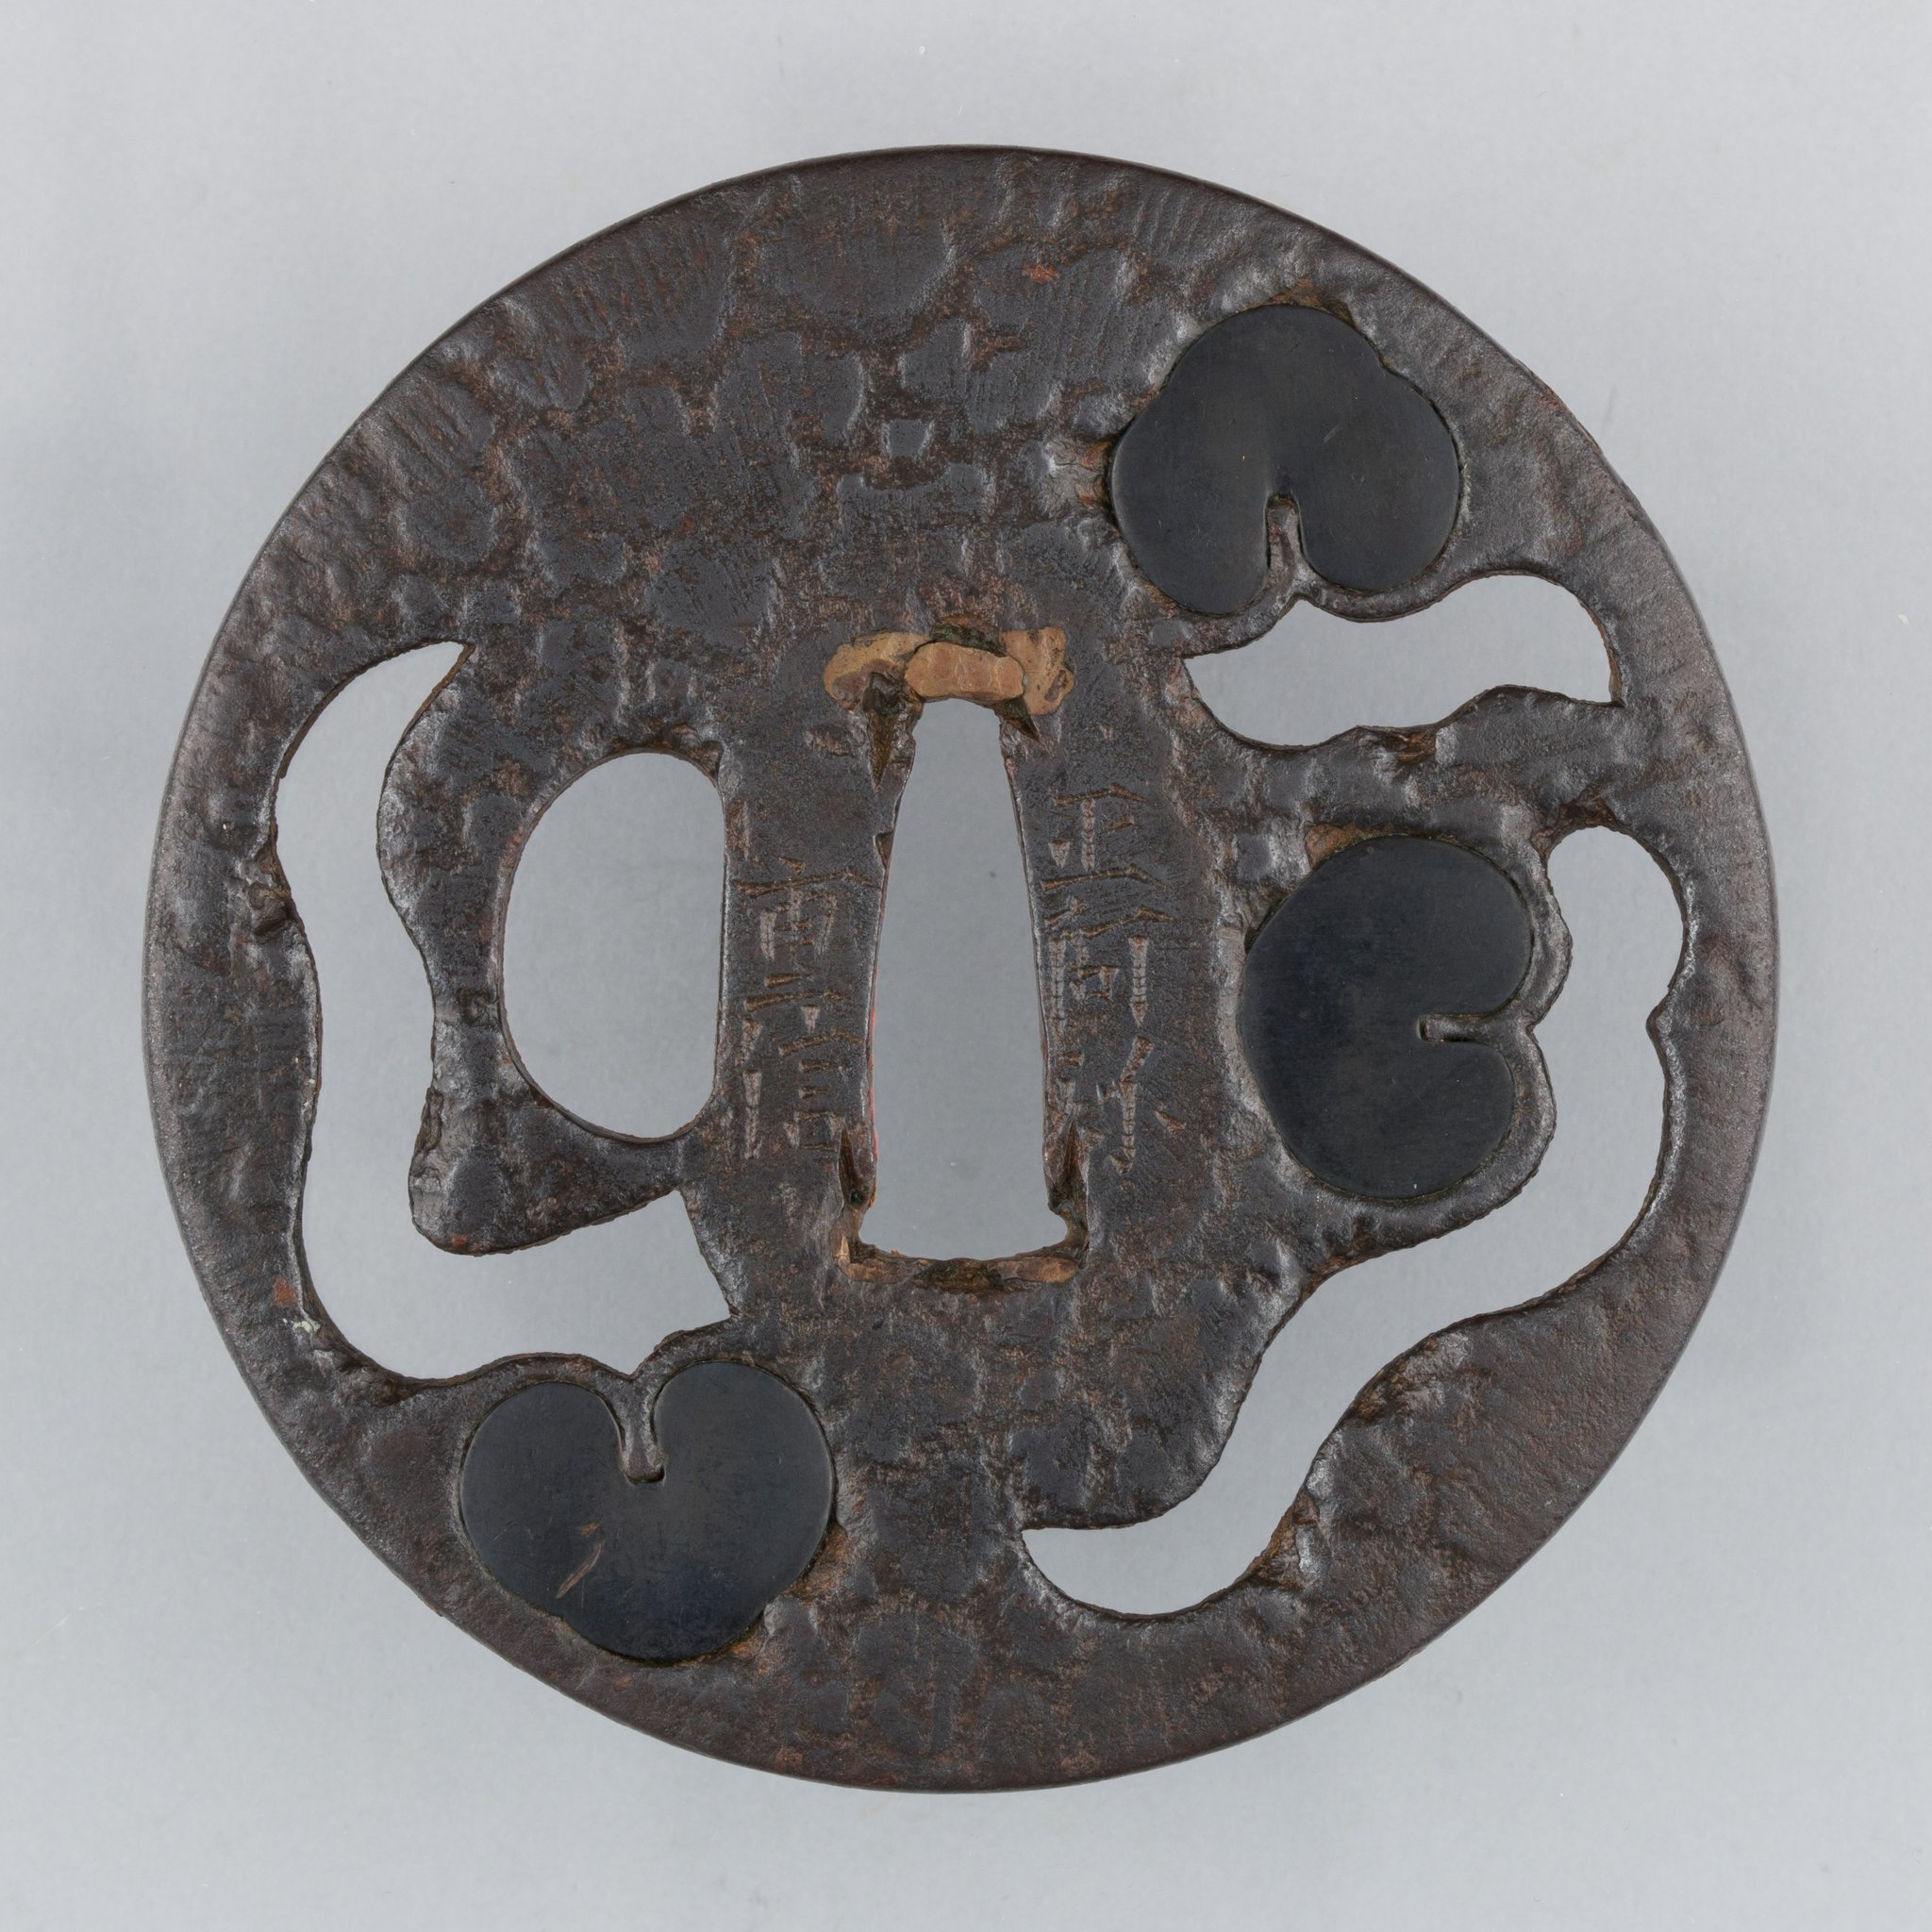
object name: sword guard tsuba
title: Sword Guard (Tsuba)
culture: japanese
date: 1800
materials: copper, gold alloy, iron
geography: japan